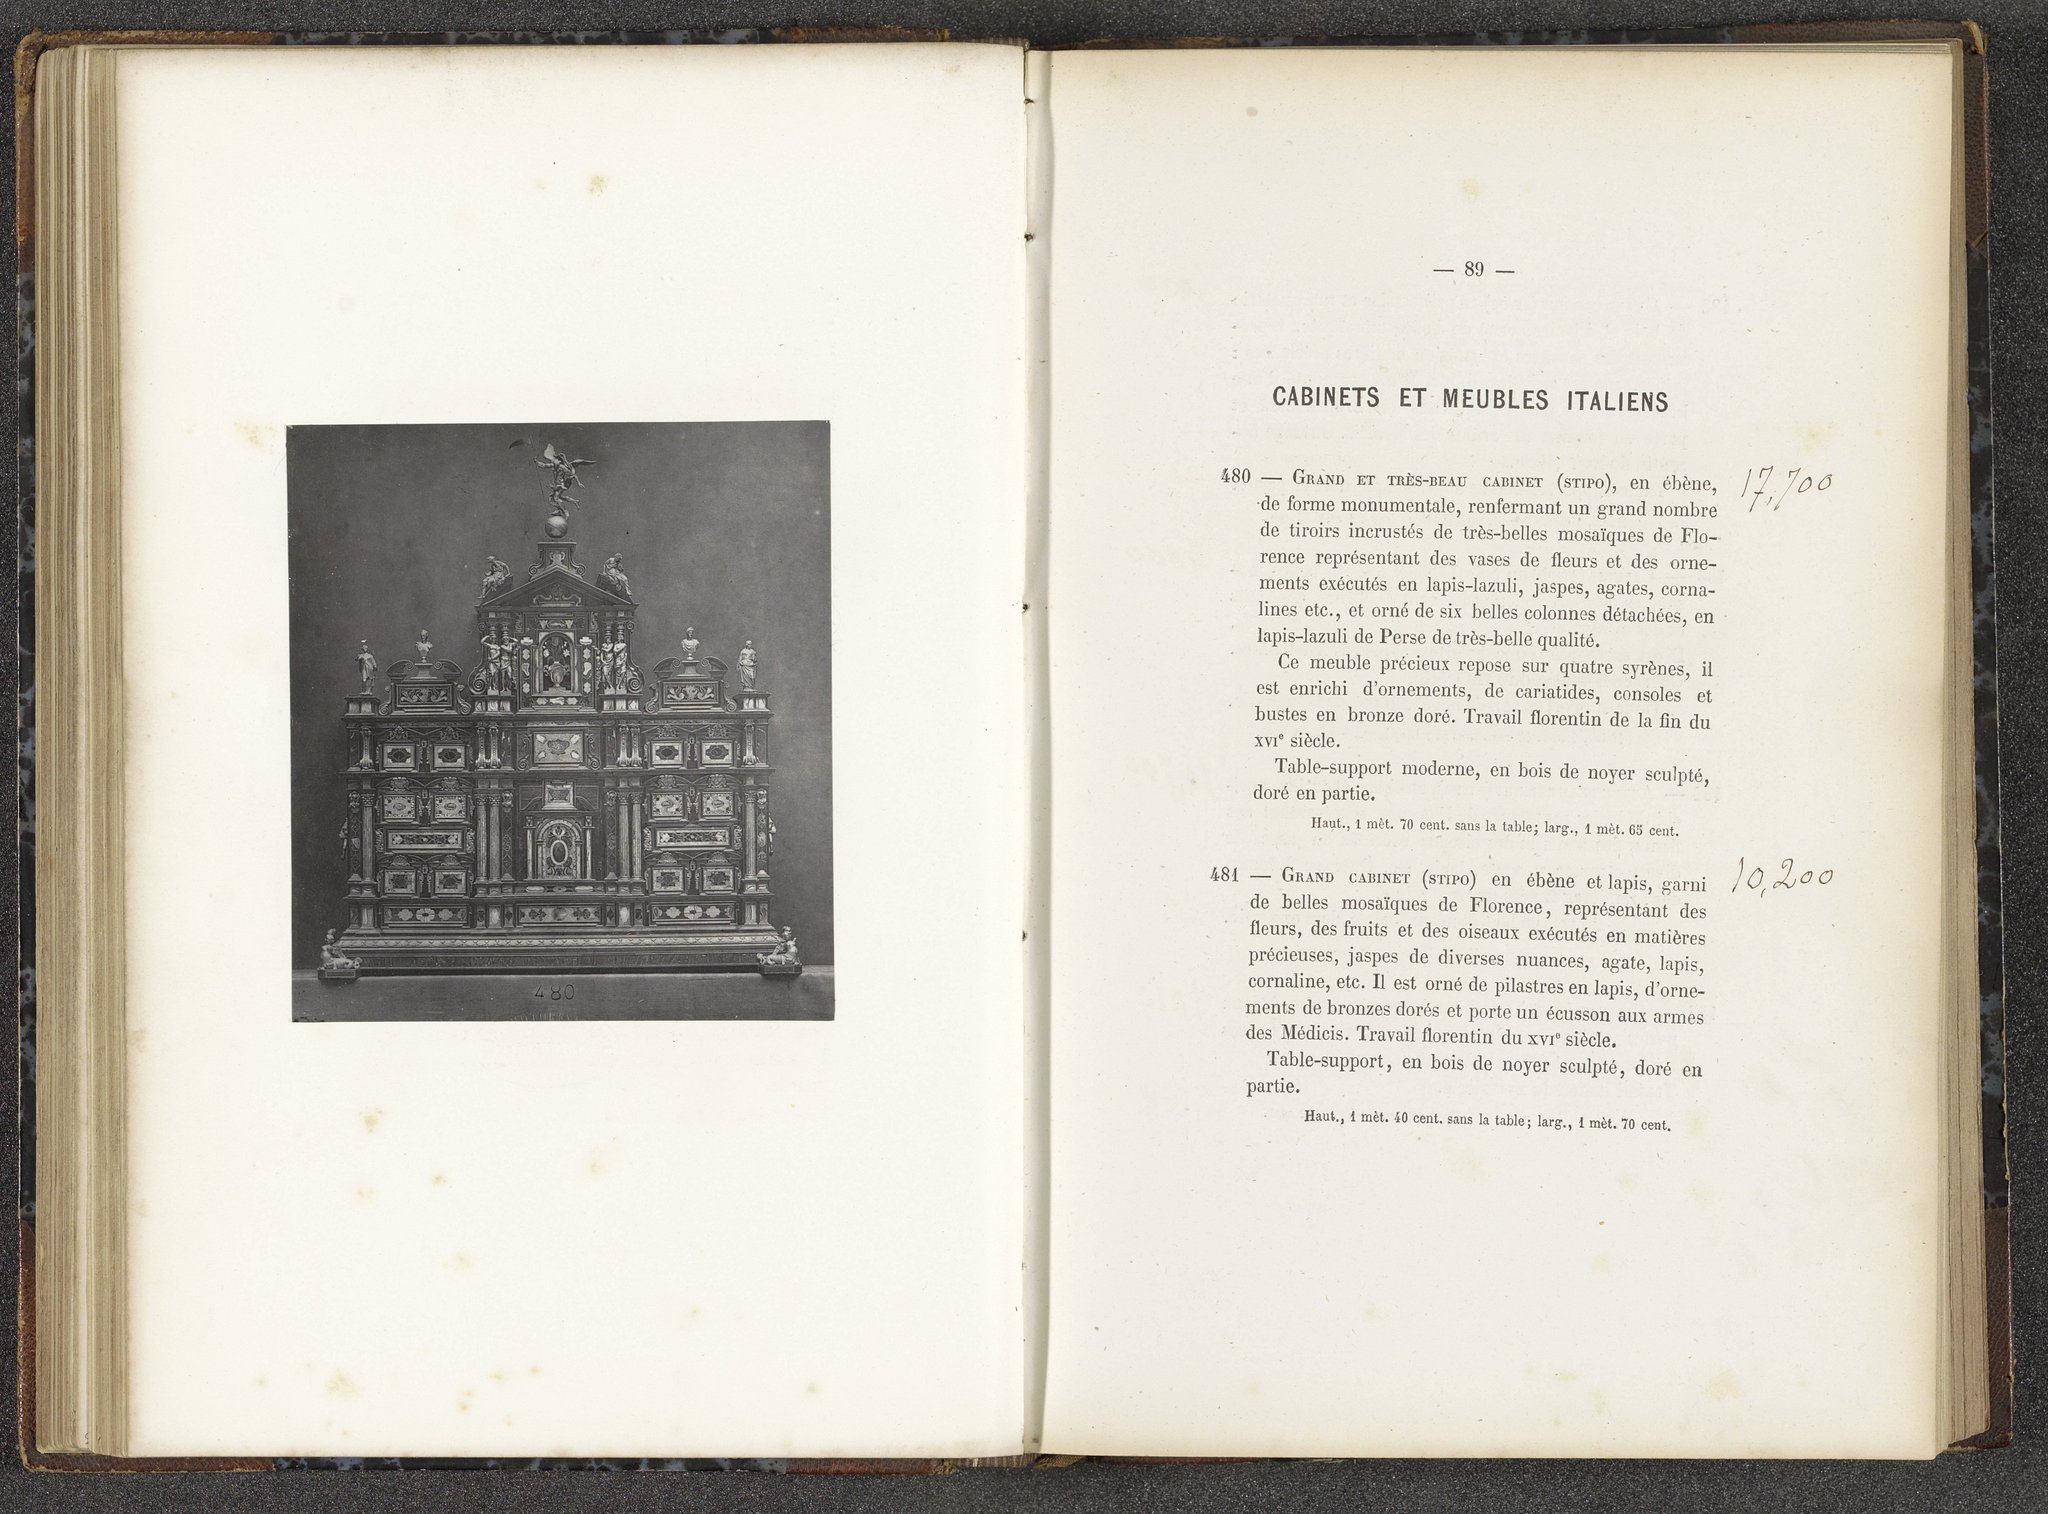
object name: page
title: Kunstkabinet gedecoreerd met consoles, kariatiden en mozaïek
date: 1870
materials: paper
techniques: woodburytype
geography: paris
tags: 'kunstschrank'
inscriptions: number: ‘480’, name: ‘De Goupil & Cie Imp. Photoglytique Paris’